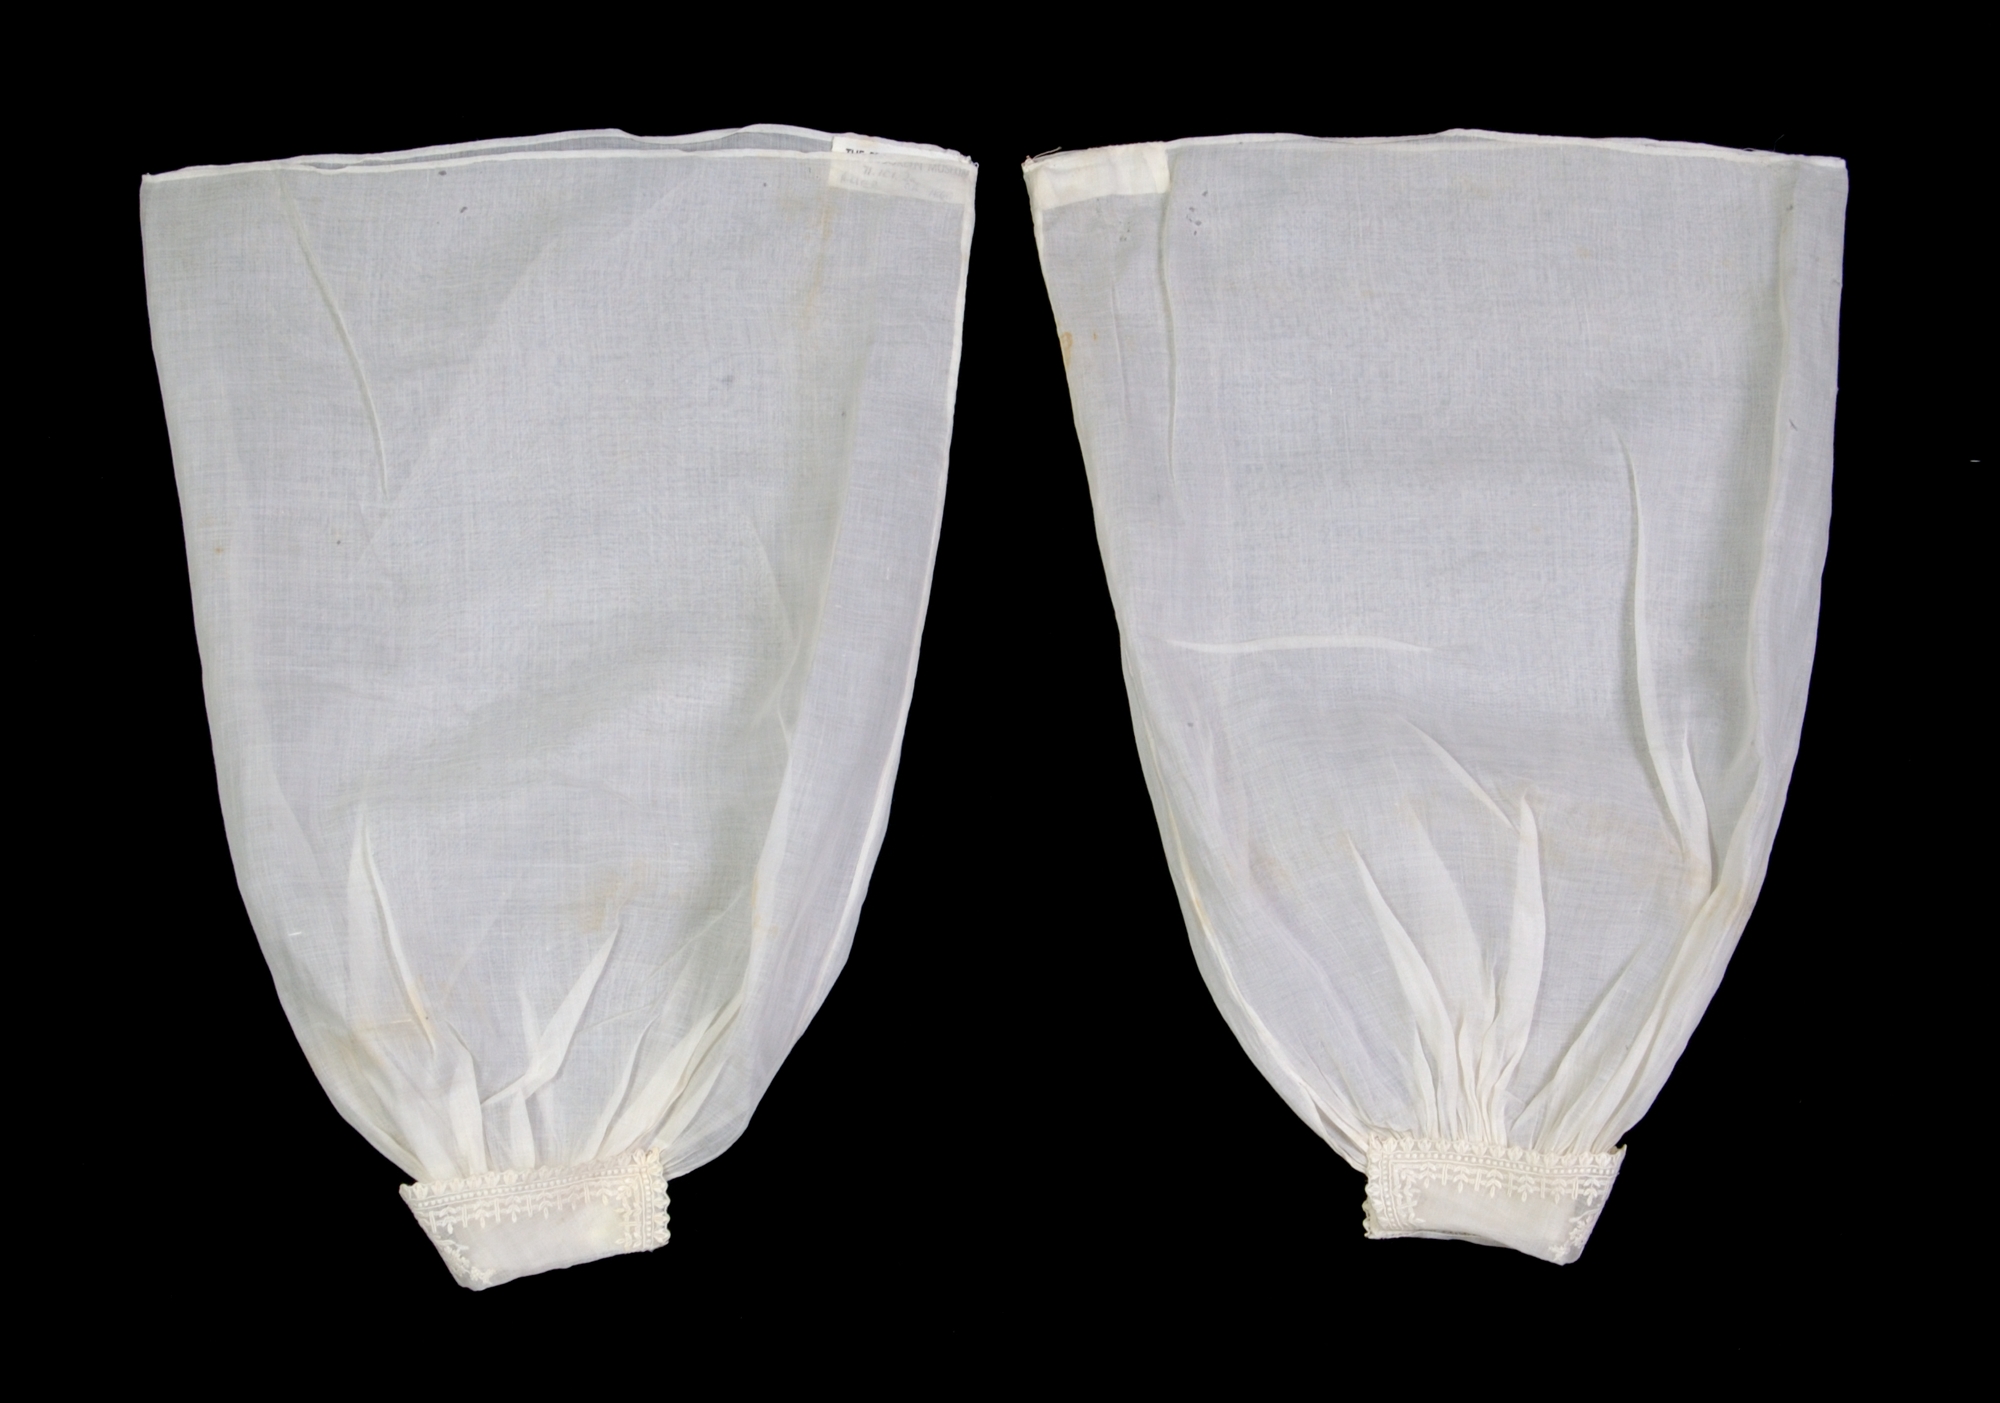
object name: undersleeves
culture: american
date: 1860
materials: linen